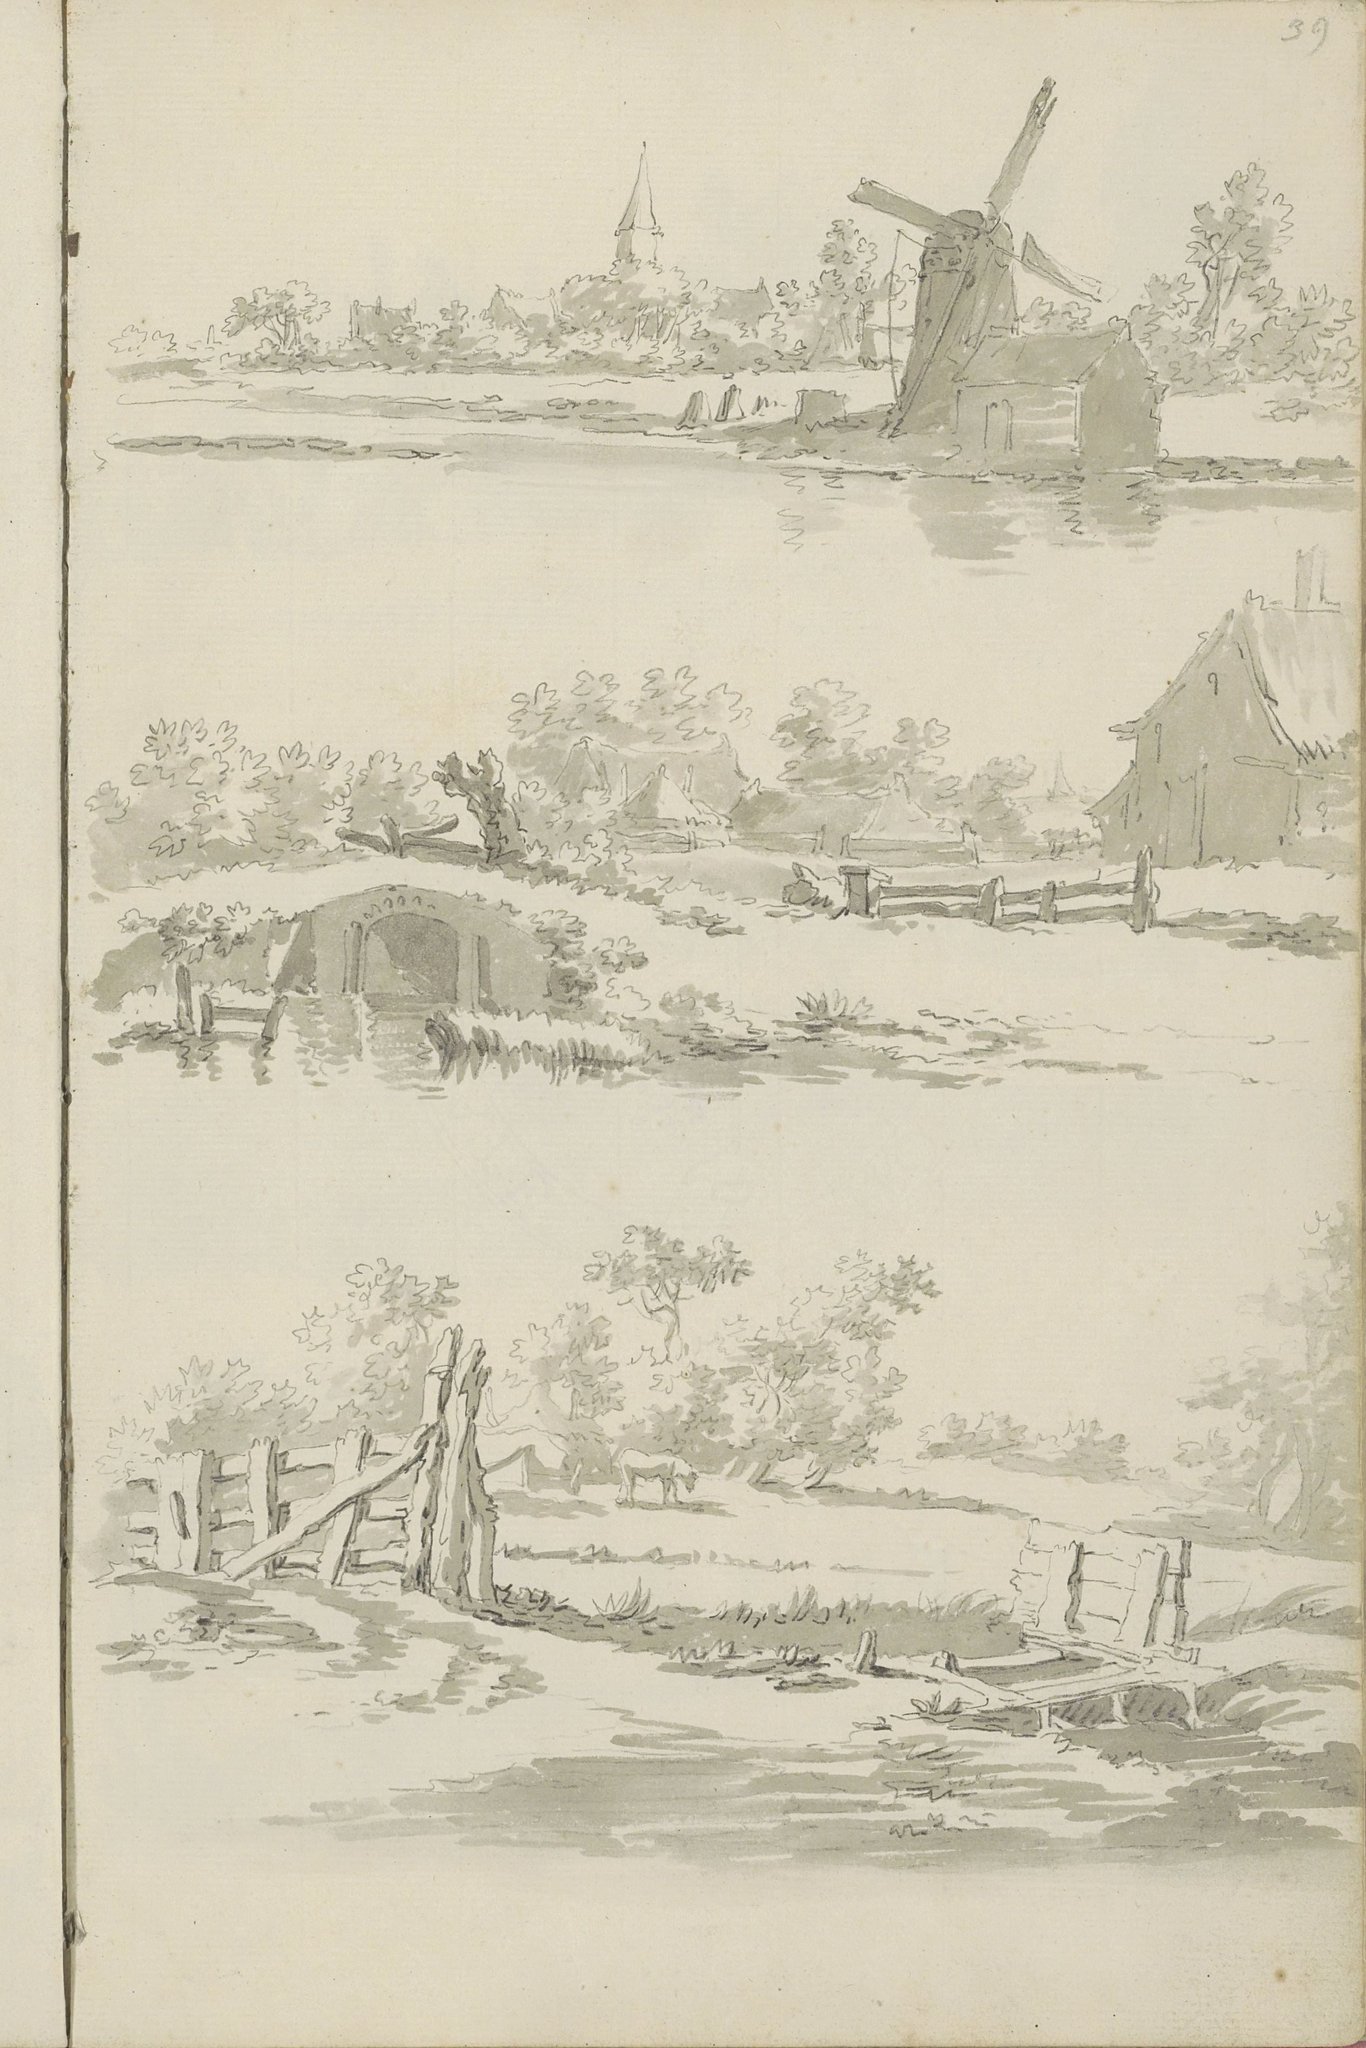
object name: sketchbook leaf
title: Landschappen met water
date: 1780-1800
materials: paper, pencil, watercolor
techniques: brush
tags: landscapes with waters, waterscapes, seascapes (in the temperate zone)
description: Blad 6 verso uit een schetsboek met 25 bladen.